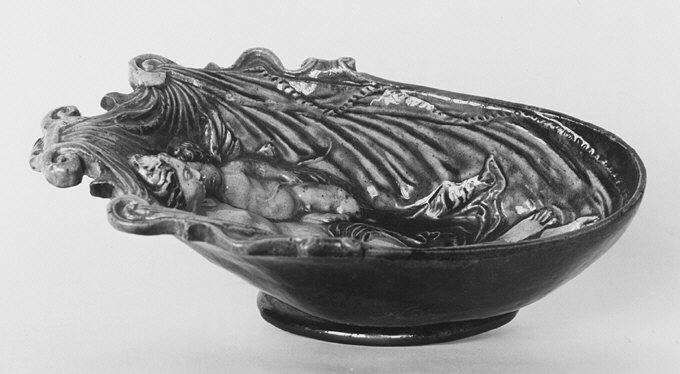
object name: gondola cup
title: Gondola cup (Coupe gondole)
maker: bernard palissy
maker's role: maker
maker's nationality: french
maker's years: 1510-1590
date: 1801-1900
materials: earthenware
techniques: glazing